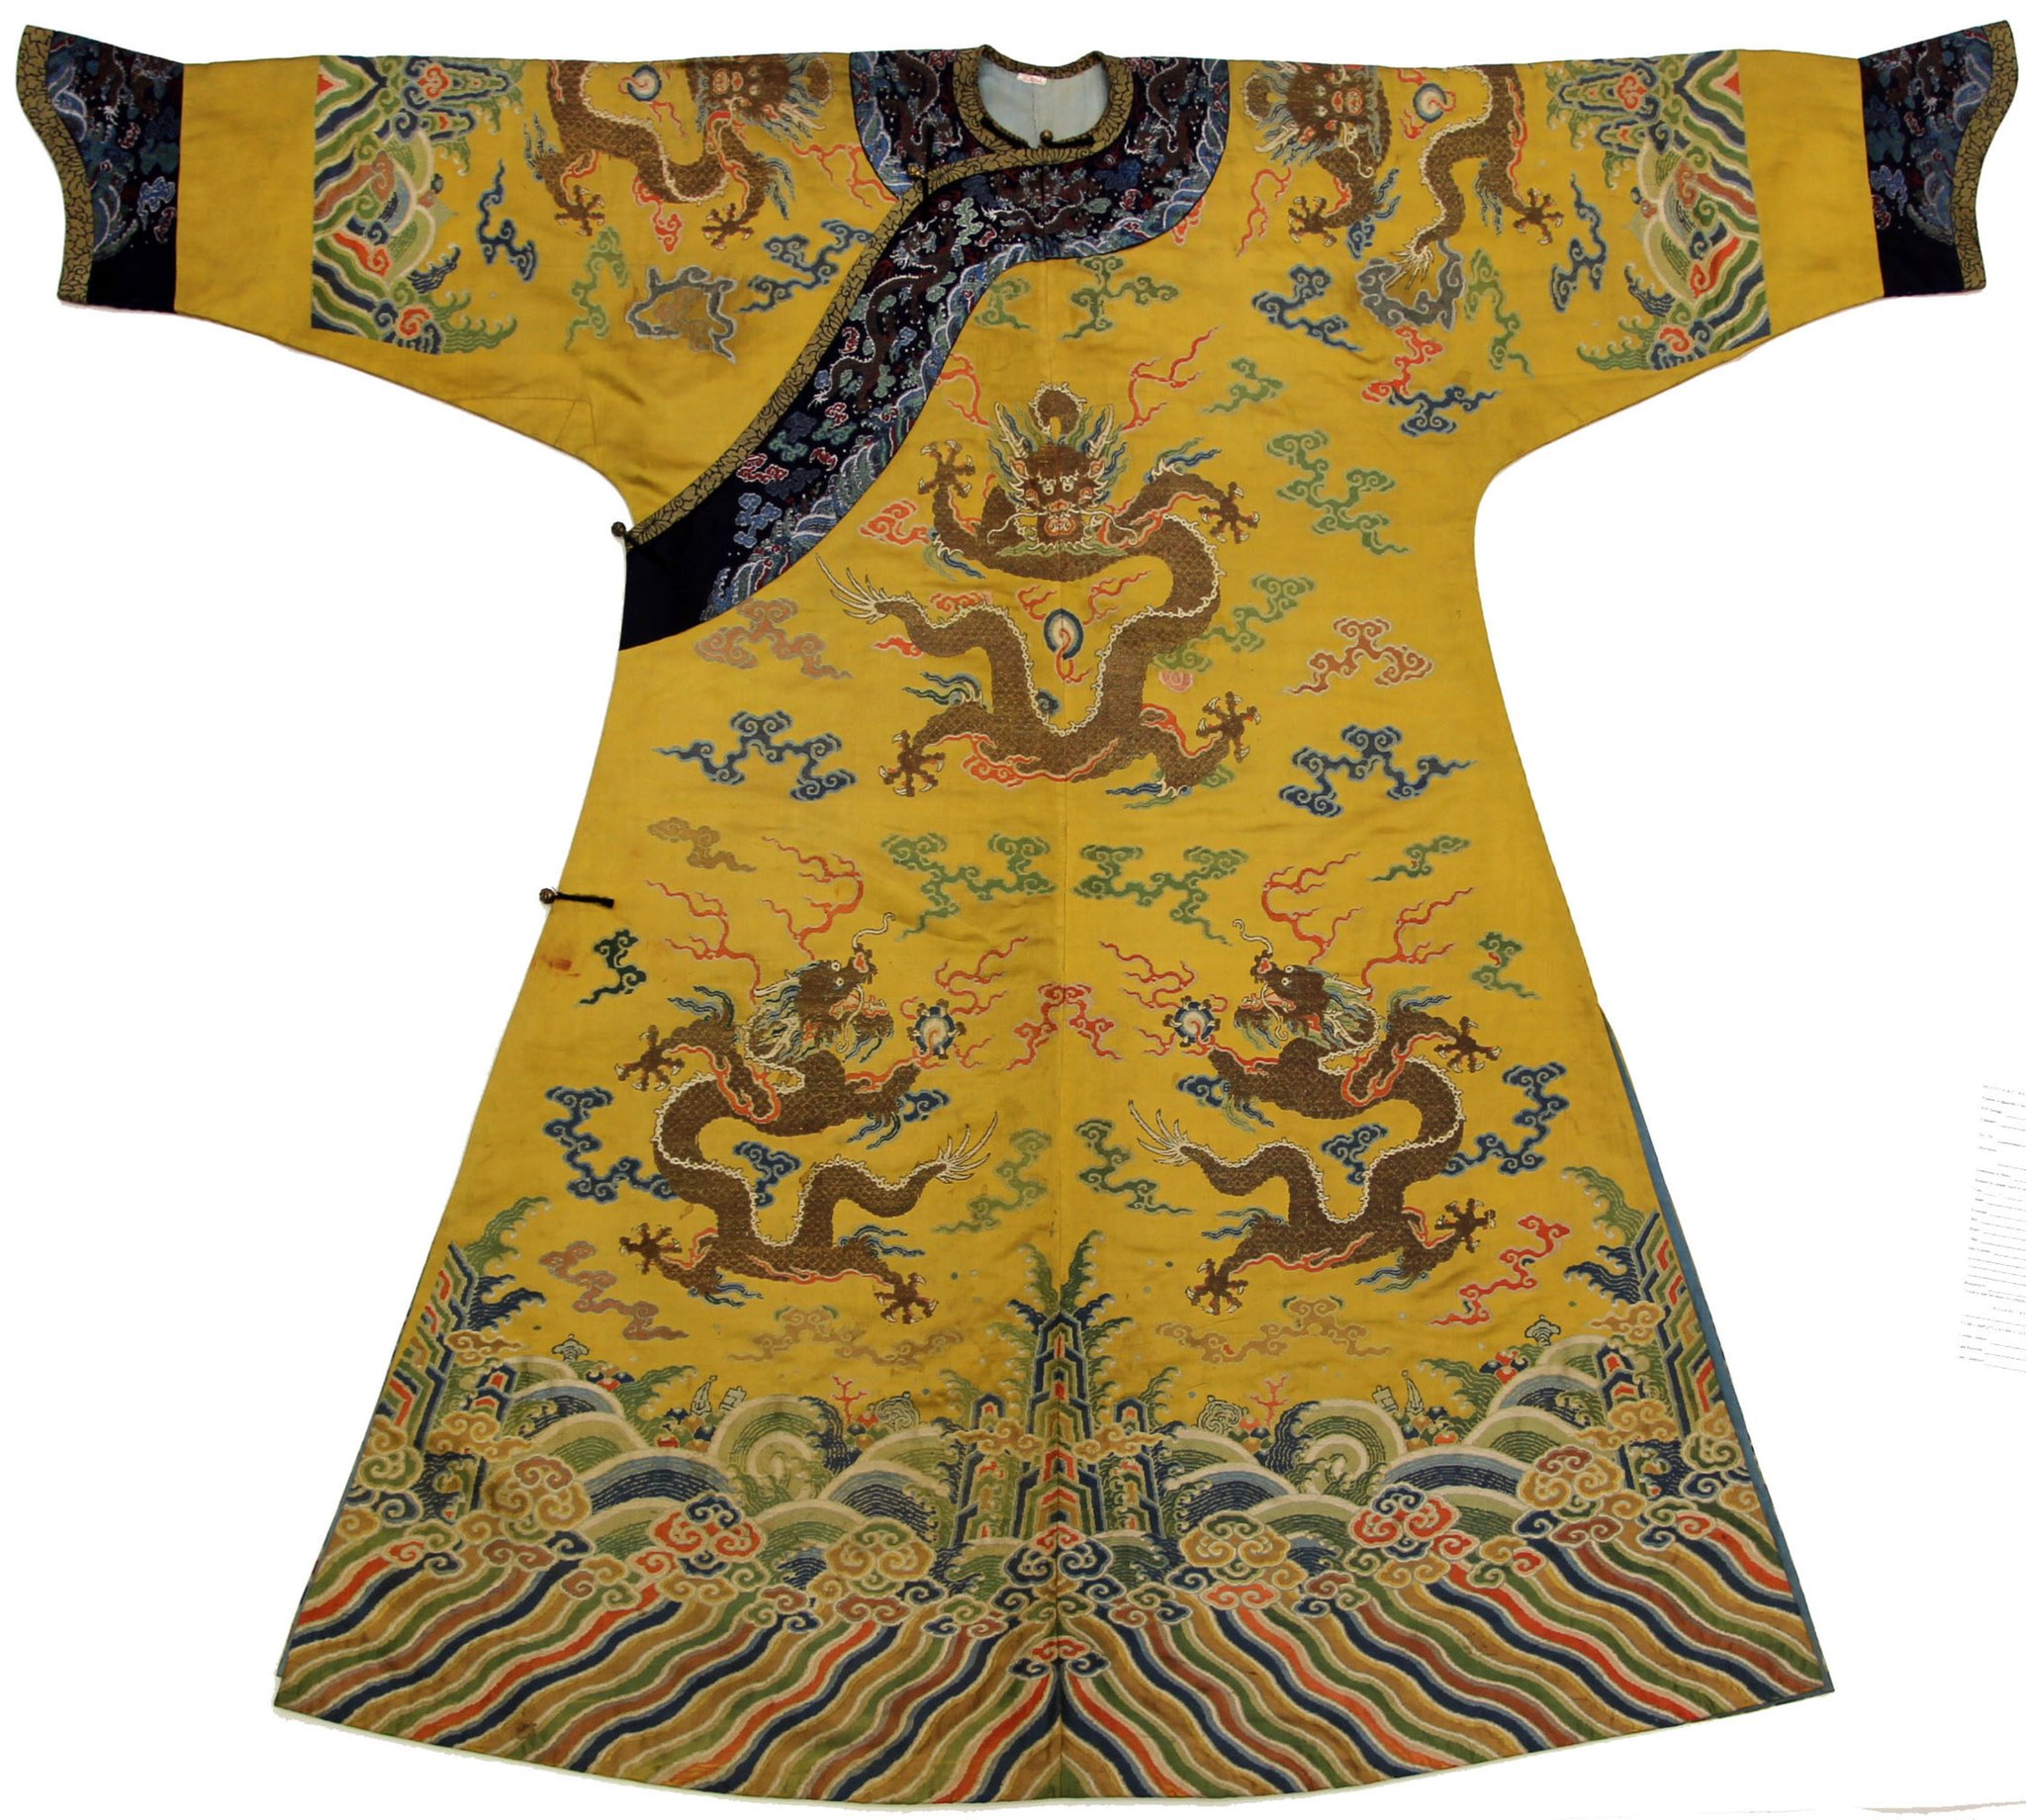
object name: robe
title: Dragon Robe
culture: chinese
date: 1701-1800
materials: silk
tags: dragons